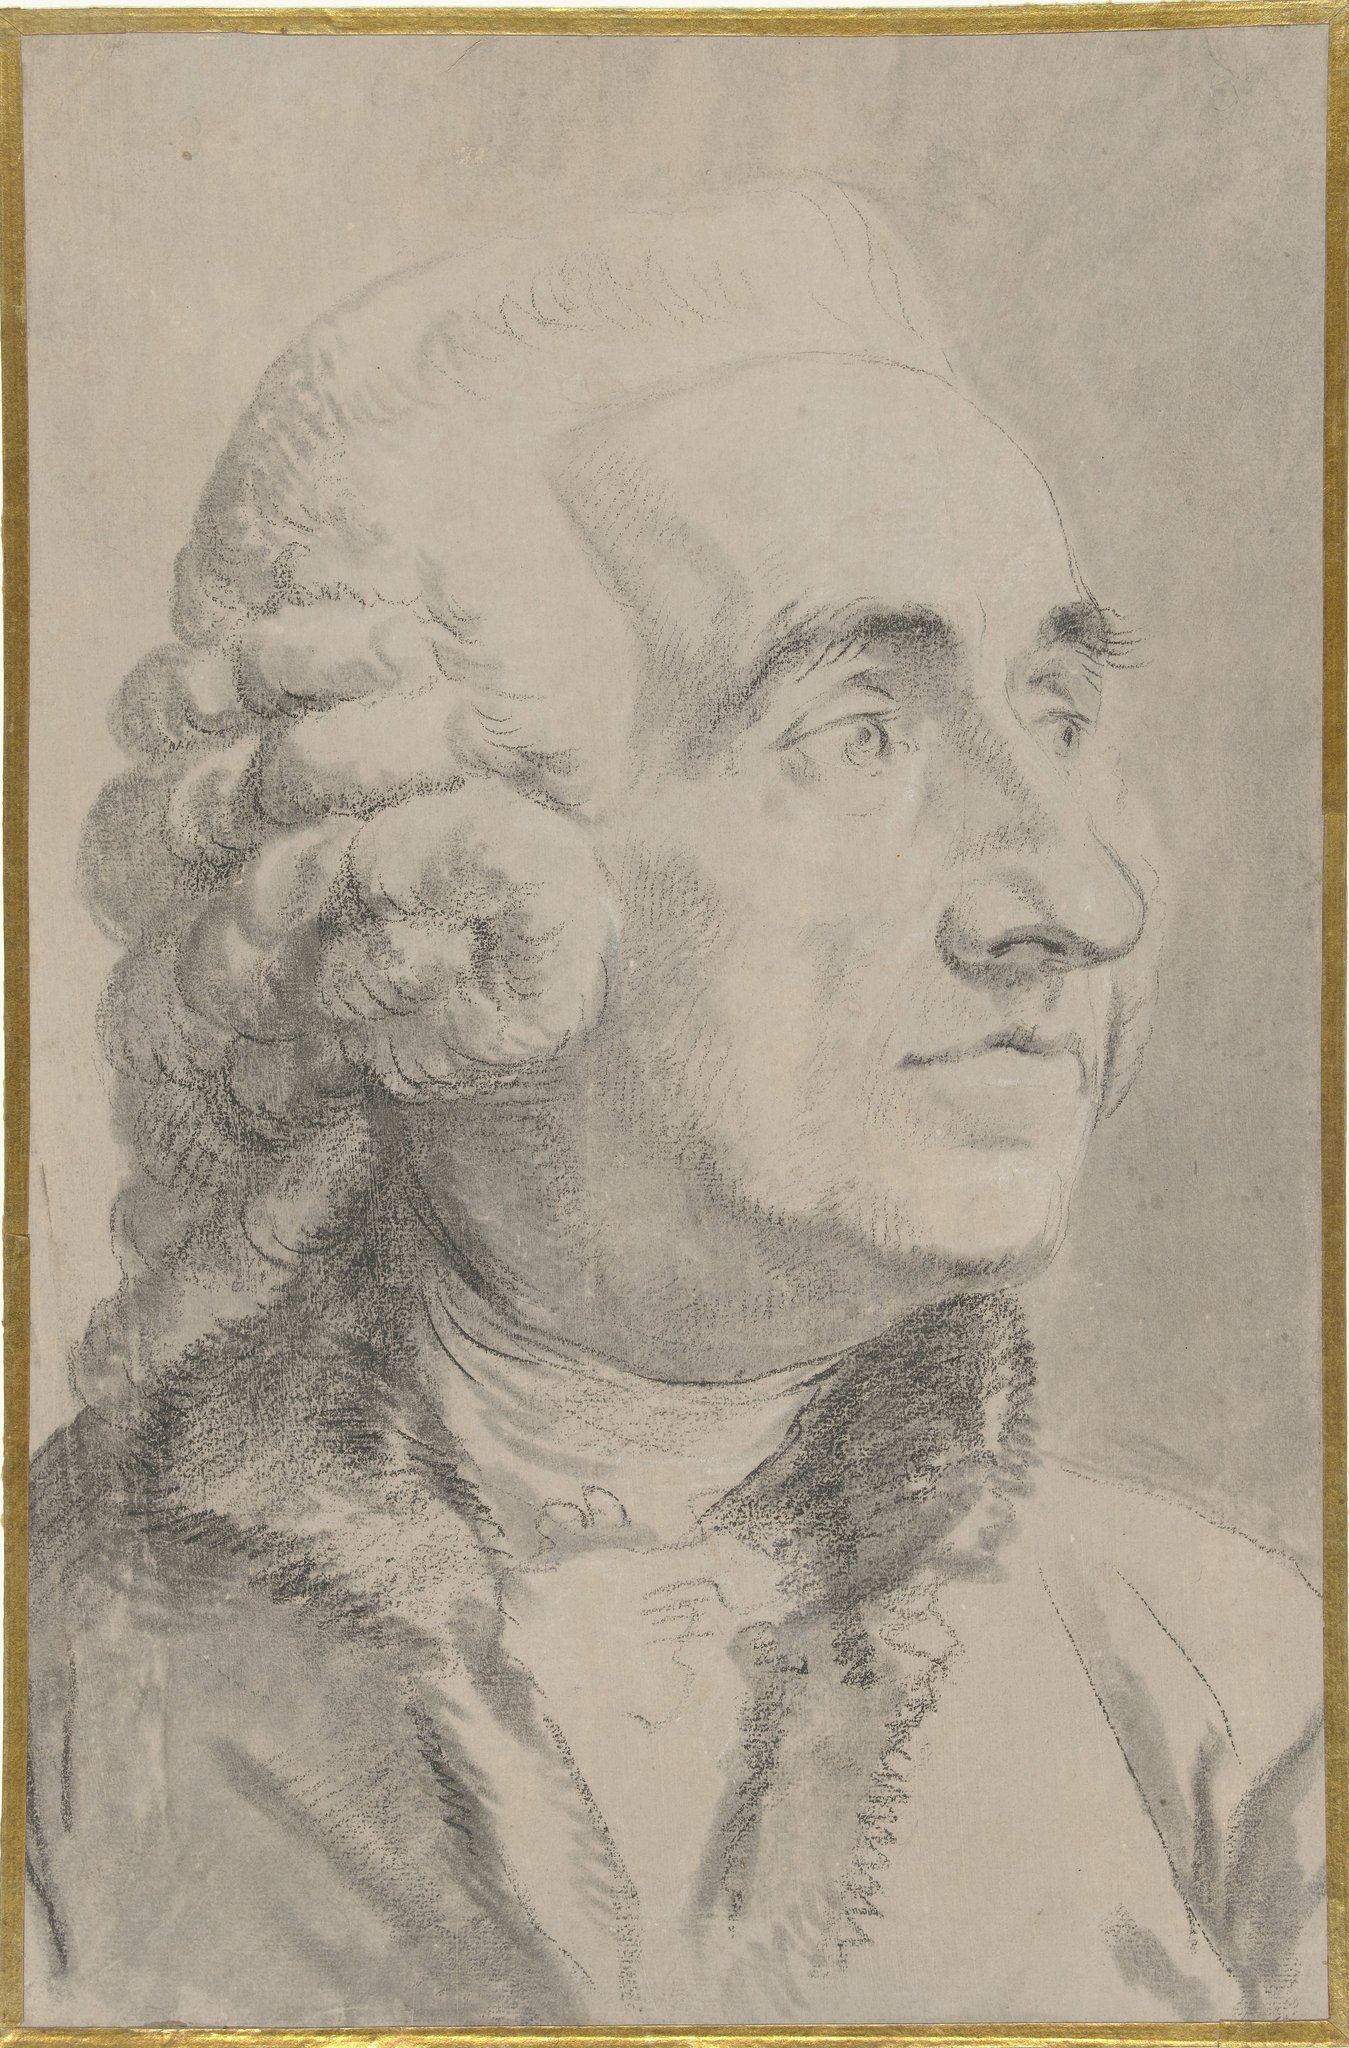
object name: drawing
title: Portret van A.C.G. Lemonnier(?)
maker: Anonymous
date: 1700-1800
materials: chalk, paper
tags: paris, painter, draughtsman, anicet charles gabriel lemonnier, historical persons, portrait, self-portrait of artist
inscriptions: annotation, verso, along the right edge, pen and ink: ‘Lemonnier’, collector's mark, verso, lower centre: Lugt 2228